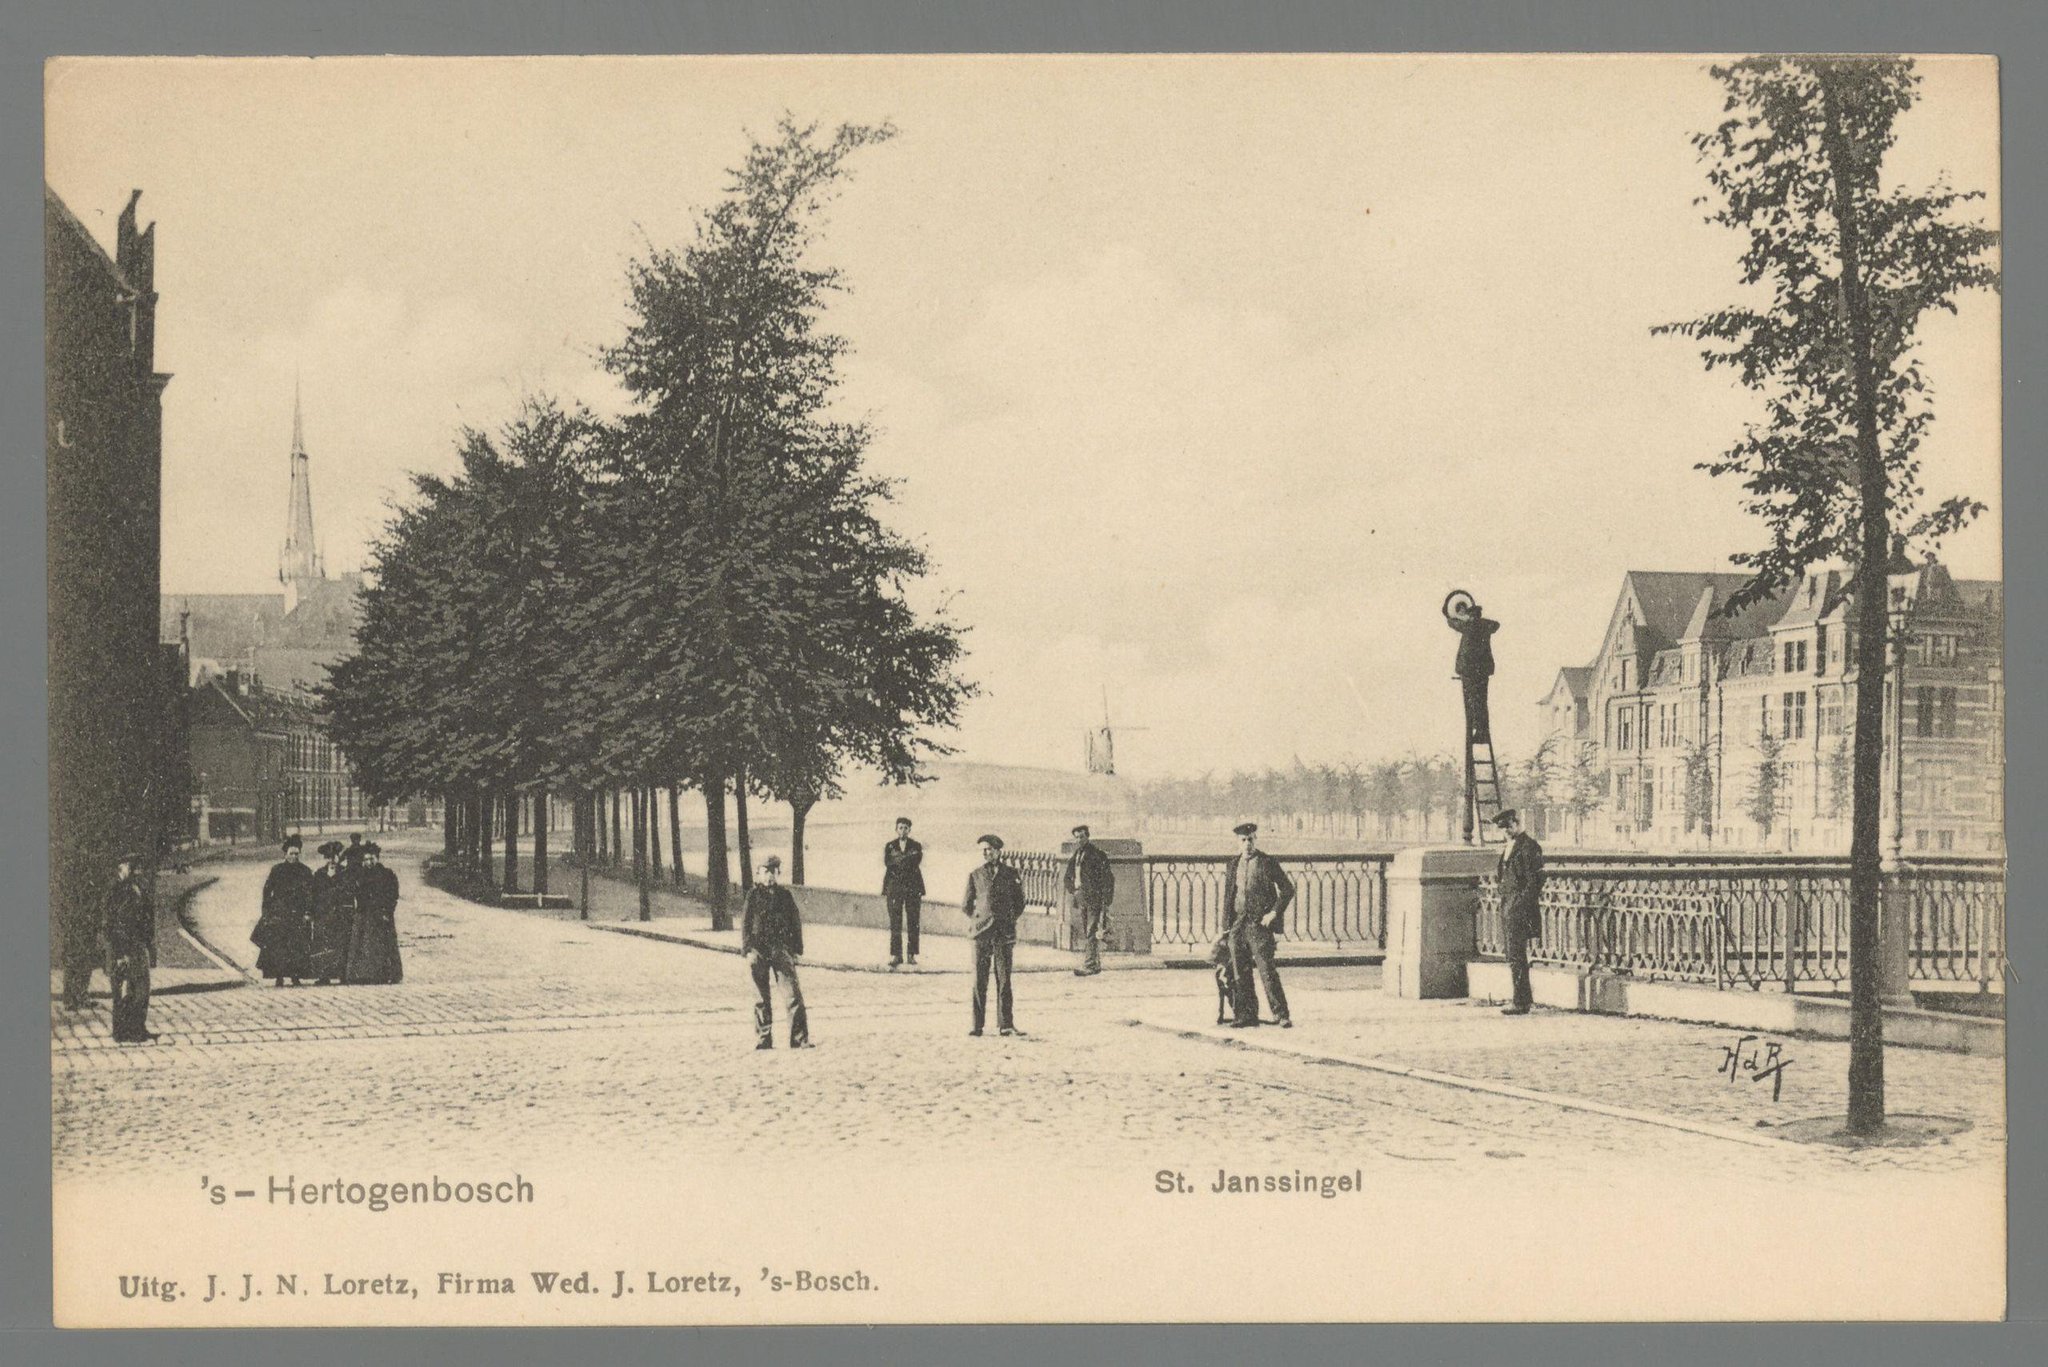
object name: photomechanical print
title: 's-Hertogenbosch. St. Janssingel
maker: Anonymous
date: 1900-1905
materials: cardboard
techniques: photograph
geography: den bosch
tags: canal, street, den bosch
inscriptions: monogram: ‘HdR’